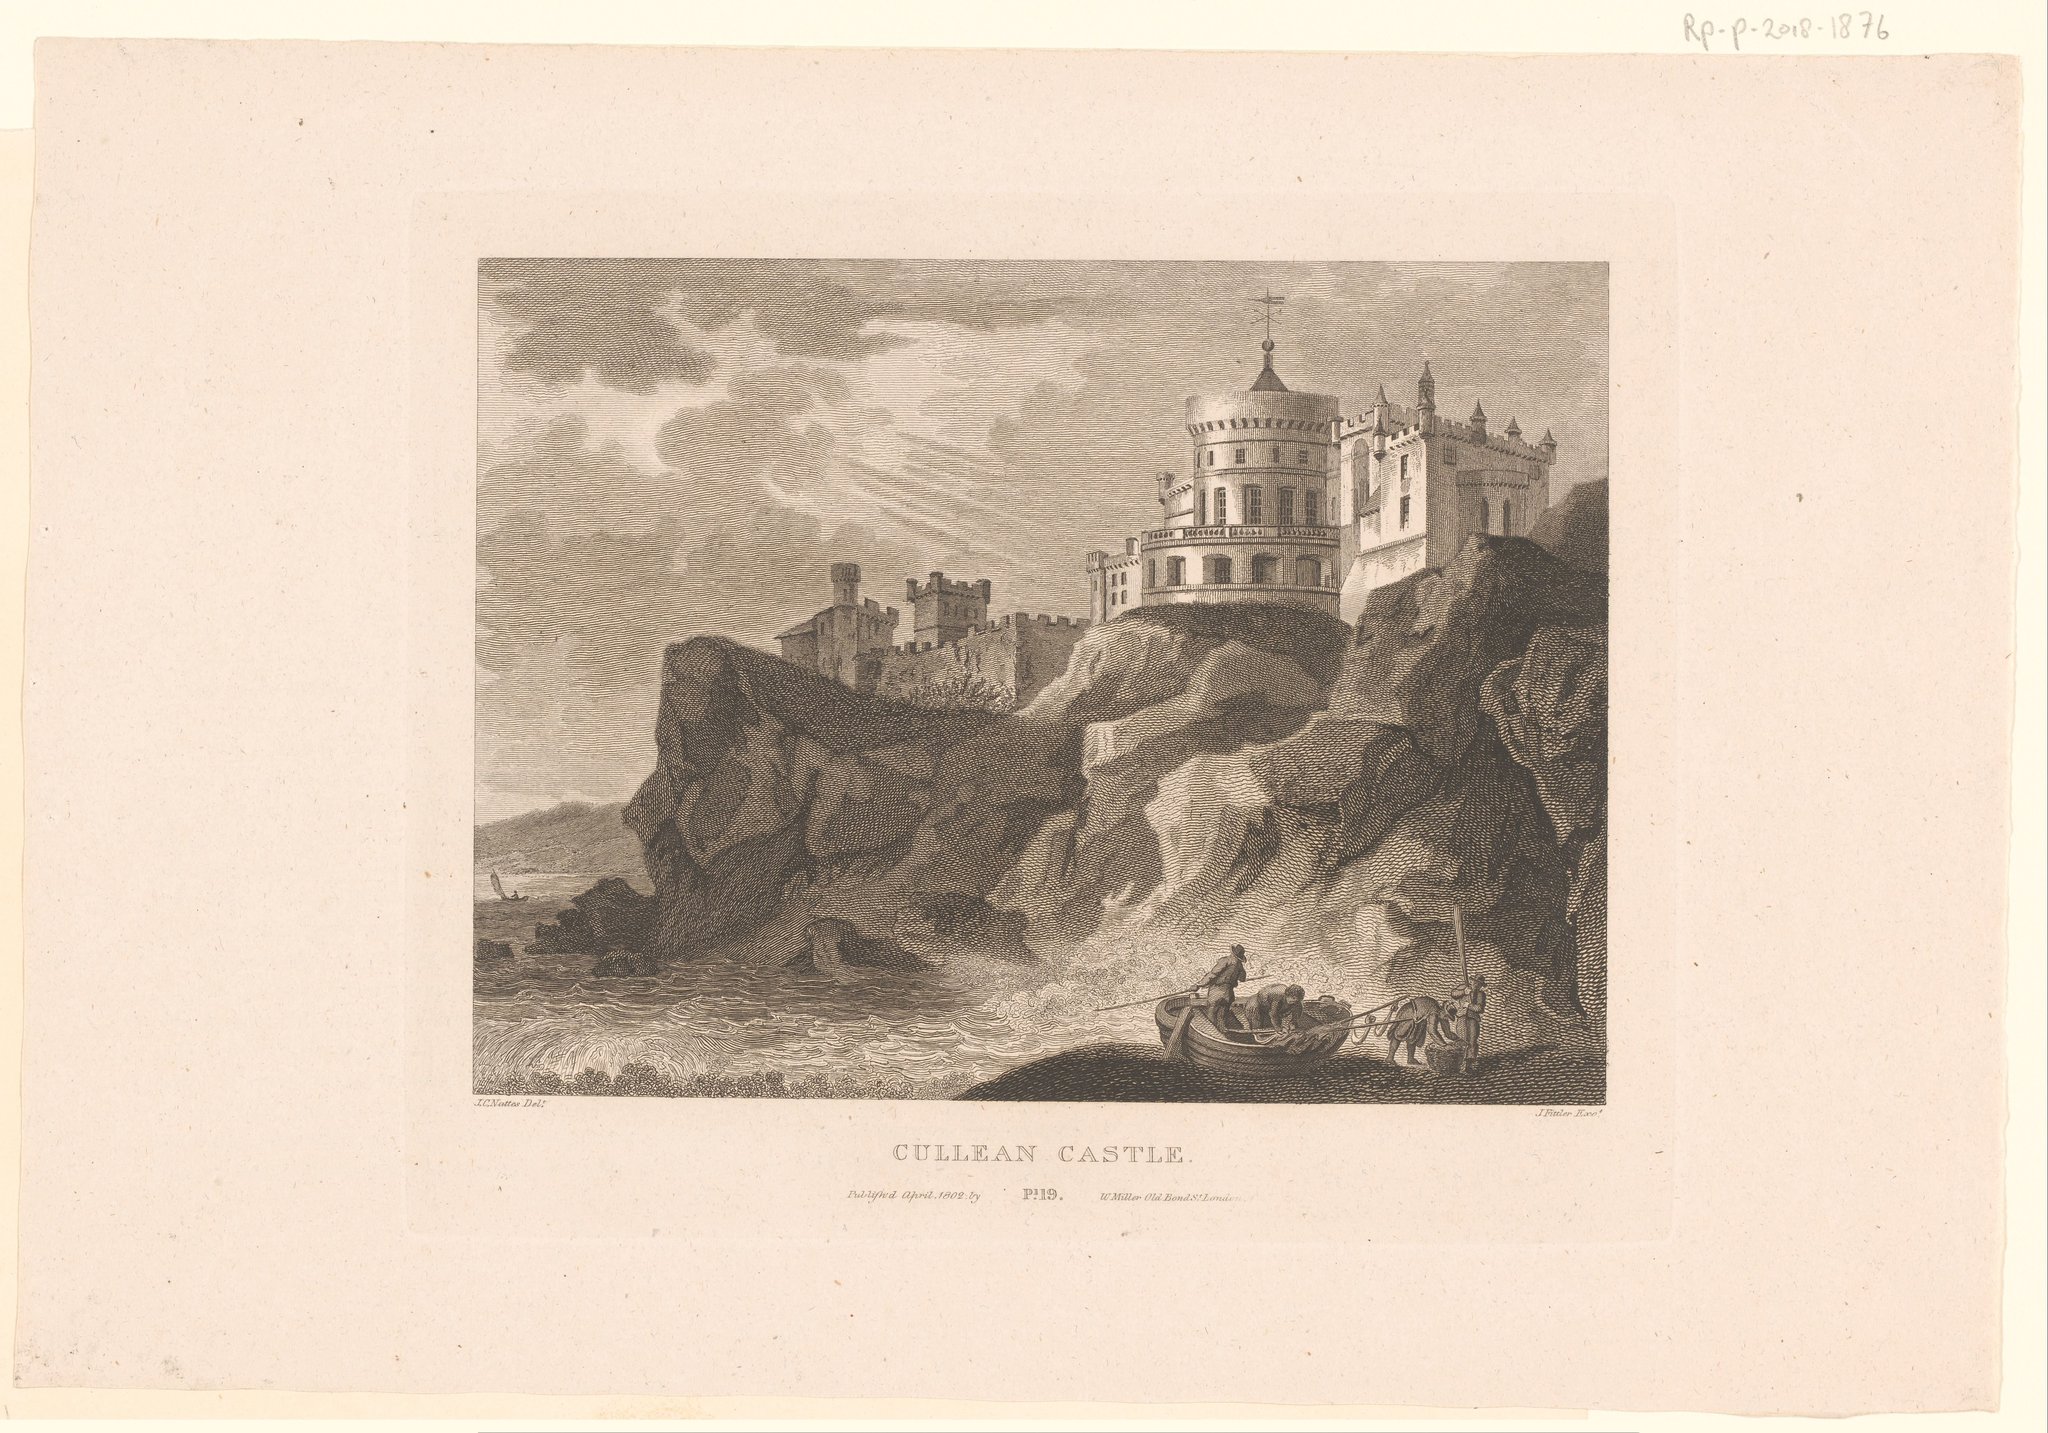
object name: print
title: Gezicht op Culzean Castle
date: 1801-1802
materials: paper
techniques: engraving, etching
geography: london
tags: castle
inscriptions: collector's mark: Lugt 2228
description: Prent gebruikt in: Scotia Depicta; or the antiquities, castles, public buildings, noblemen (...). Londen: William Miller, 1801. Zie ook: RP-P-2018-1877.